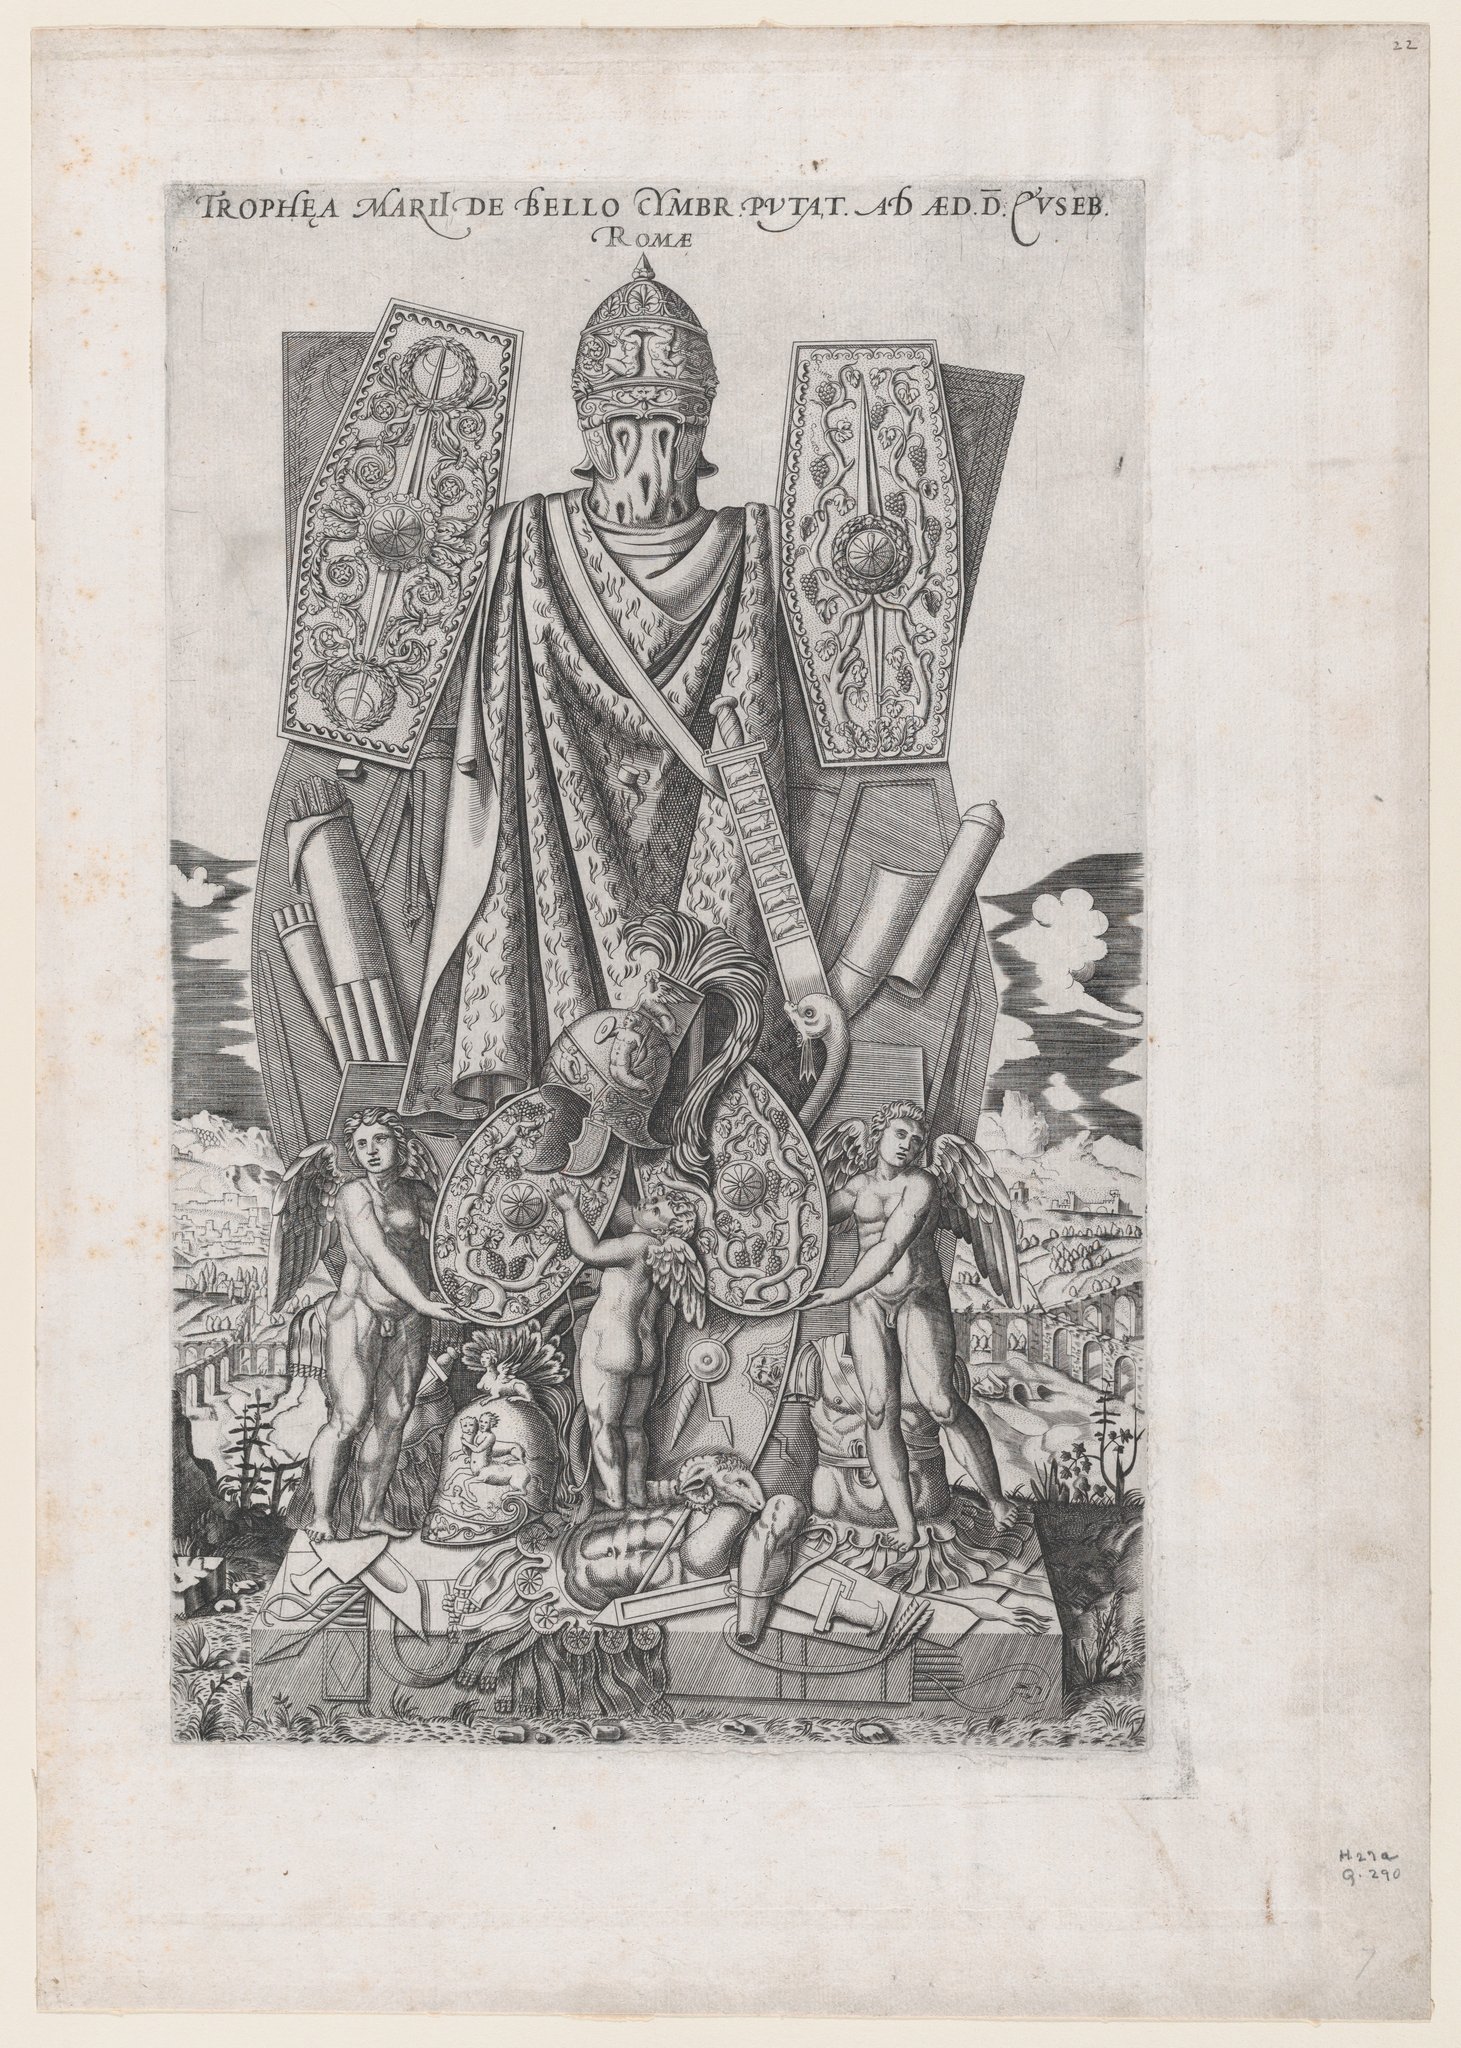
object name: print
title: Trophies of Marius, from "Speculum Romanae Magnificentiae"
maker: Anonymous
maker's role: artist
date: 1501-1600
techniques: engraving, etching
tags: shields